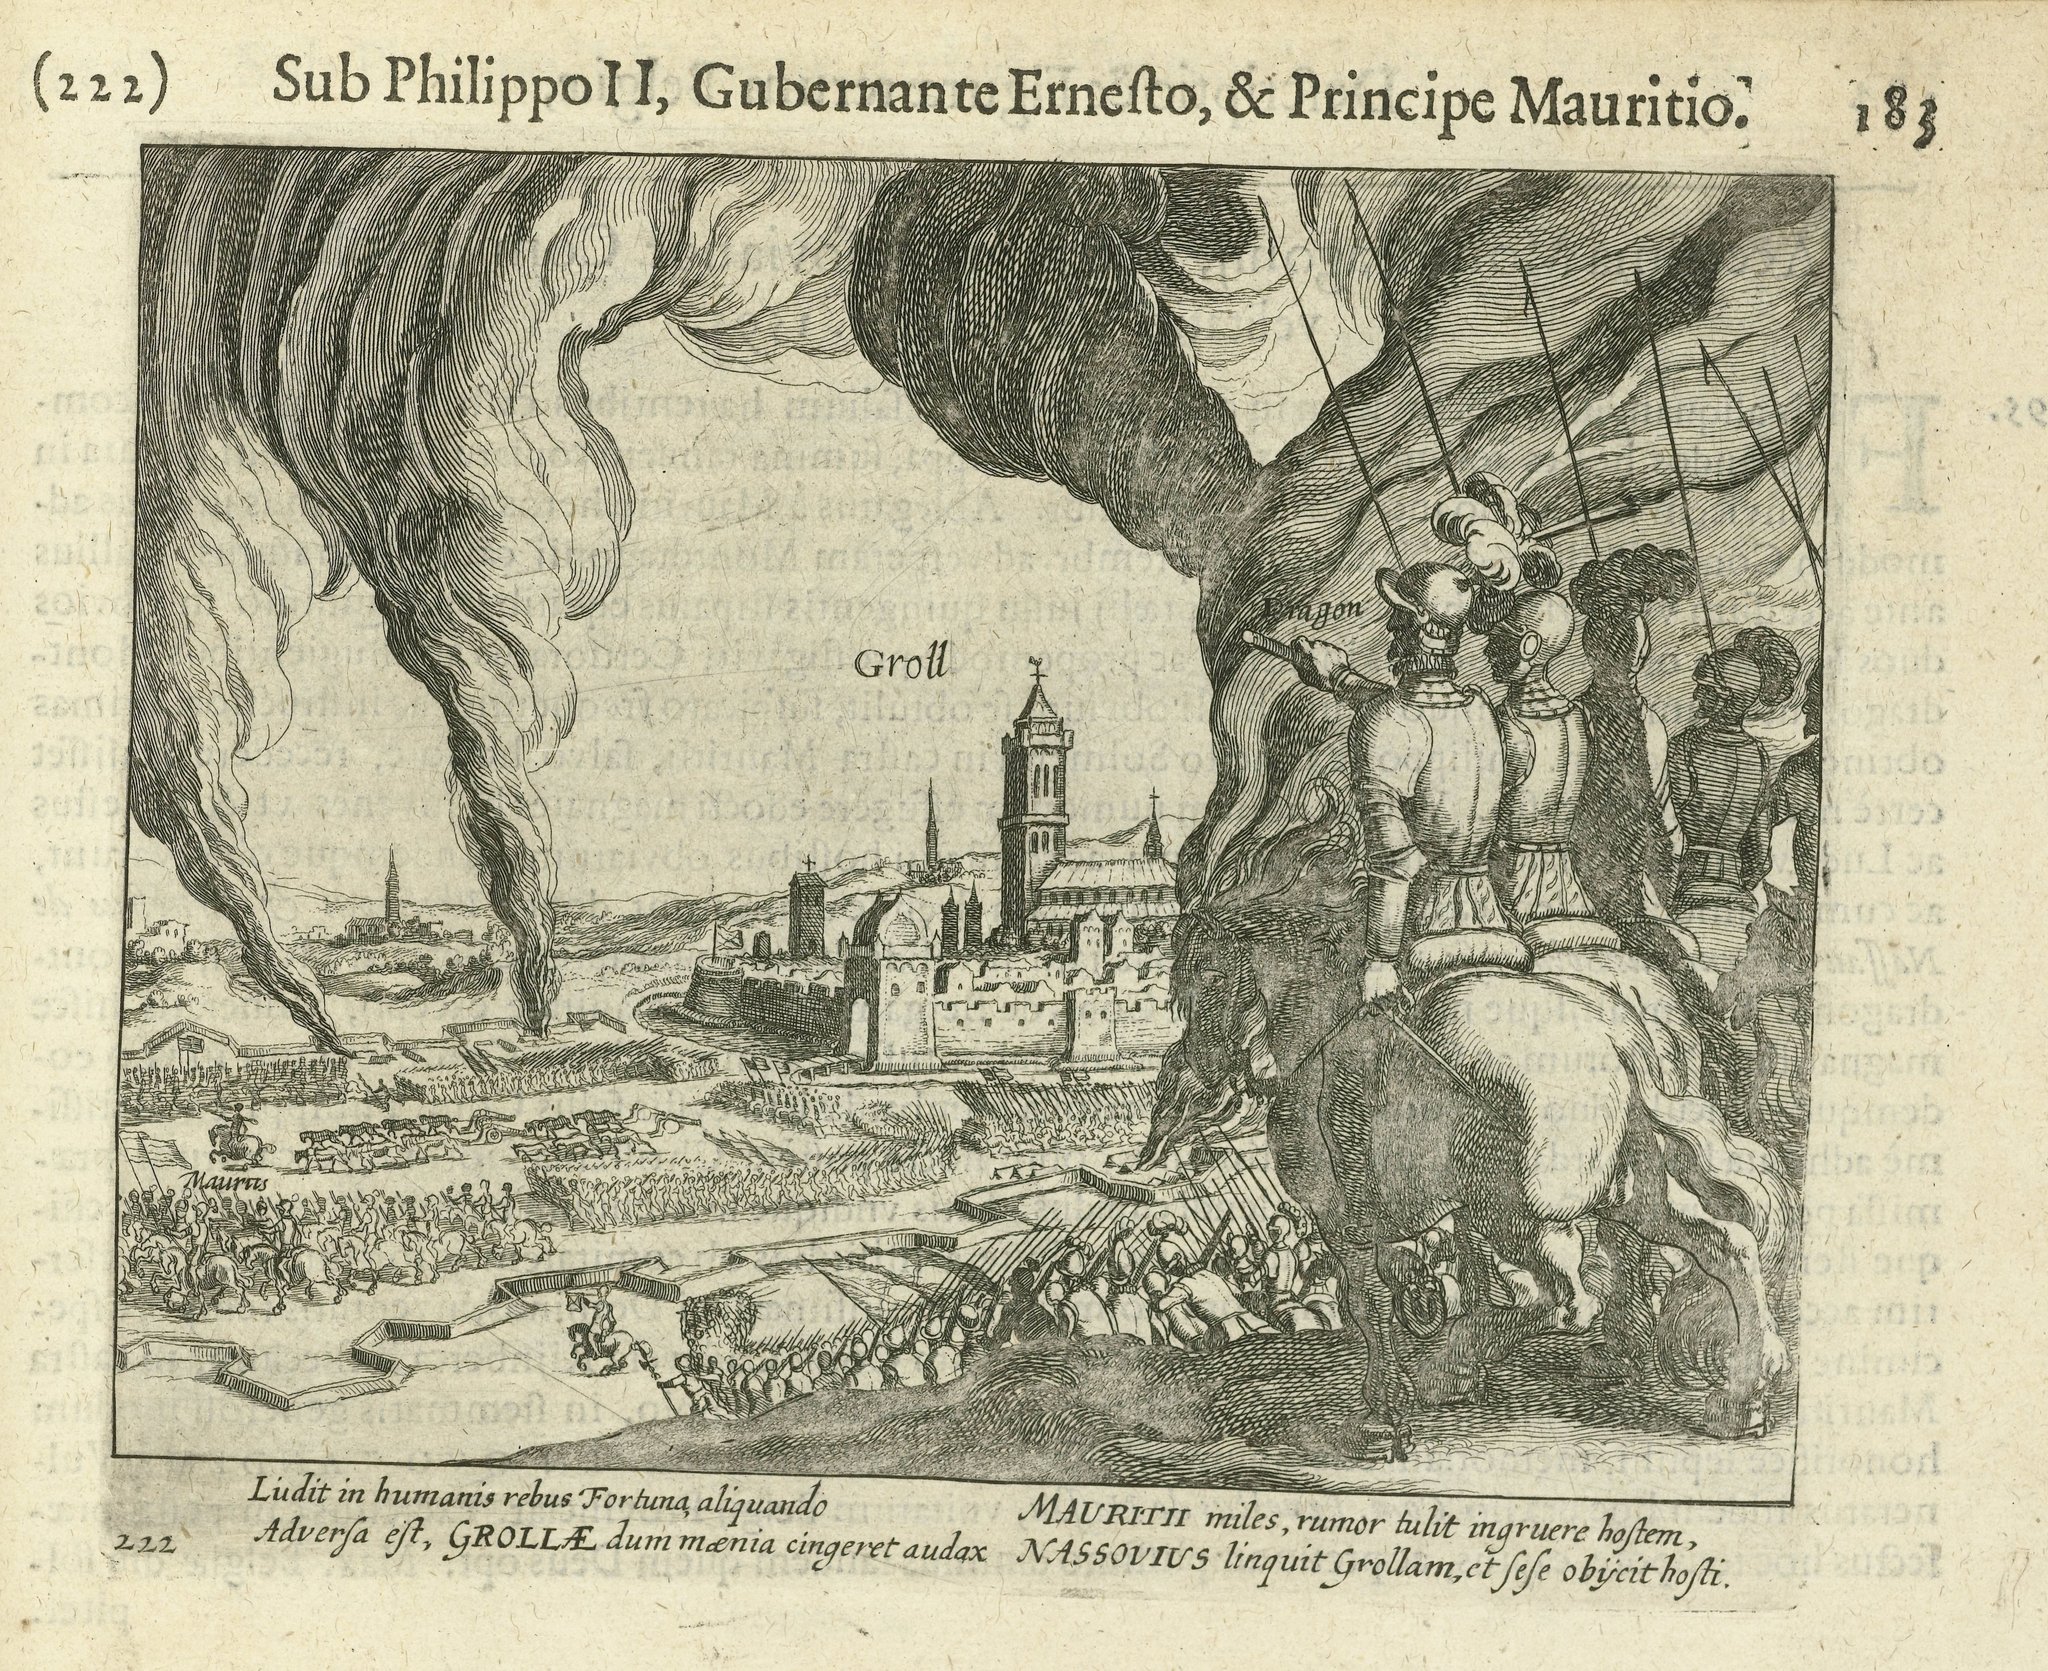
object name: print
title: Maurits breekt het beleg van Grol op, 1595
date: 1613-1615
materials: paper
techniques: etching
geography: amsterdam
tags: maurice (prince of orange), raising the siege with outside assistance, relief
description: Maurits breekt het beleg van Grol, het tegenwoordige Groenlo, op, 18 juli 1595. Grol wordt ontzet, het beleg door prins Maurits aangevangen op 4 juli wordt afgebroken. Het leger van Mondragon ziet toe hoe het Staatse leger de aftocht blaast. Met onderschrift van 4 regels in het Latijn. Genummerd: 222. Bedrukt op achterzijde met tekst in het Latijn.